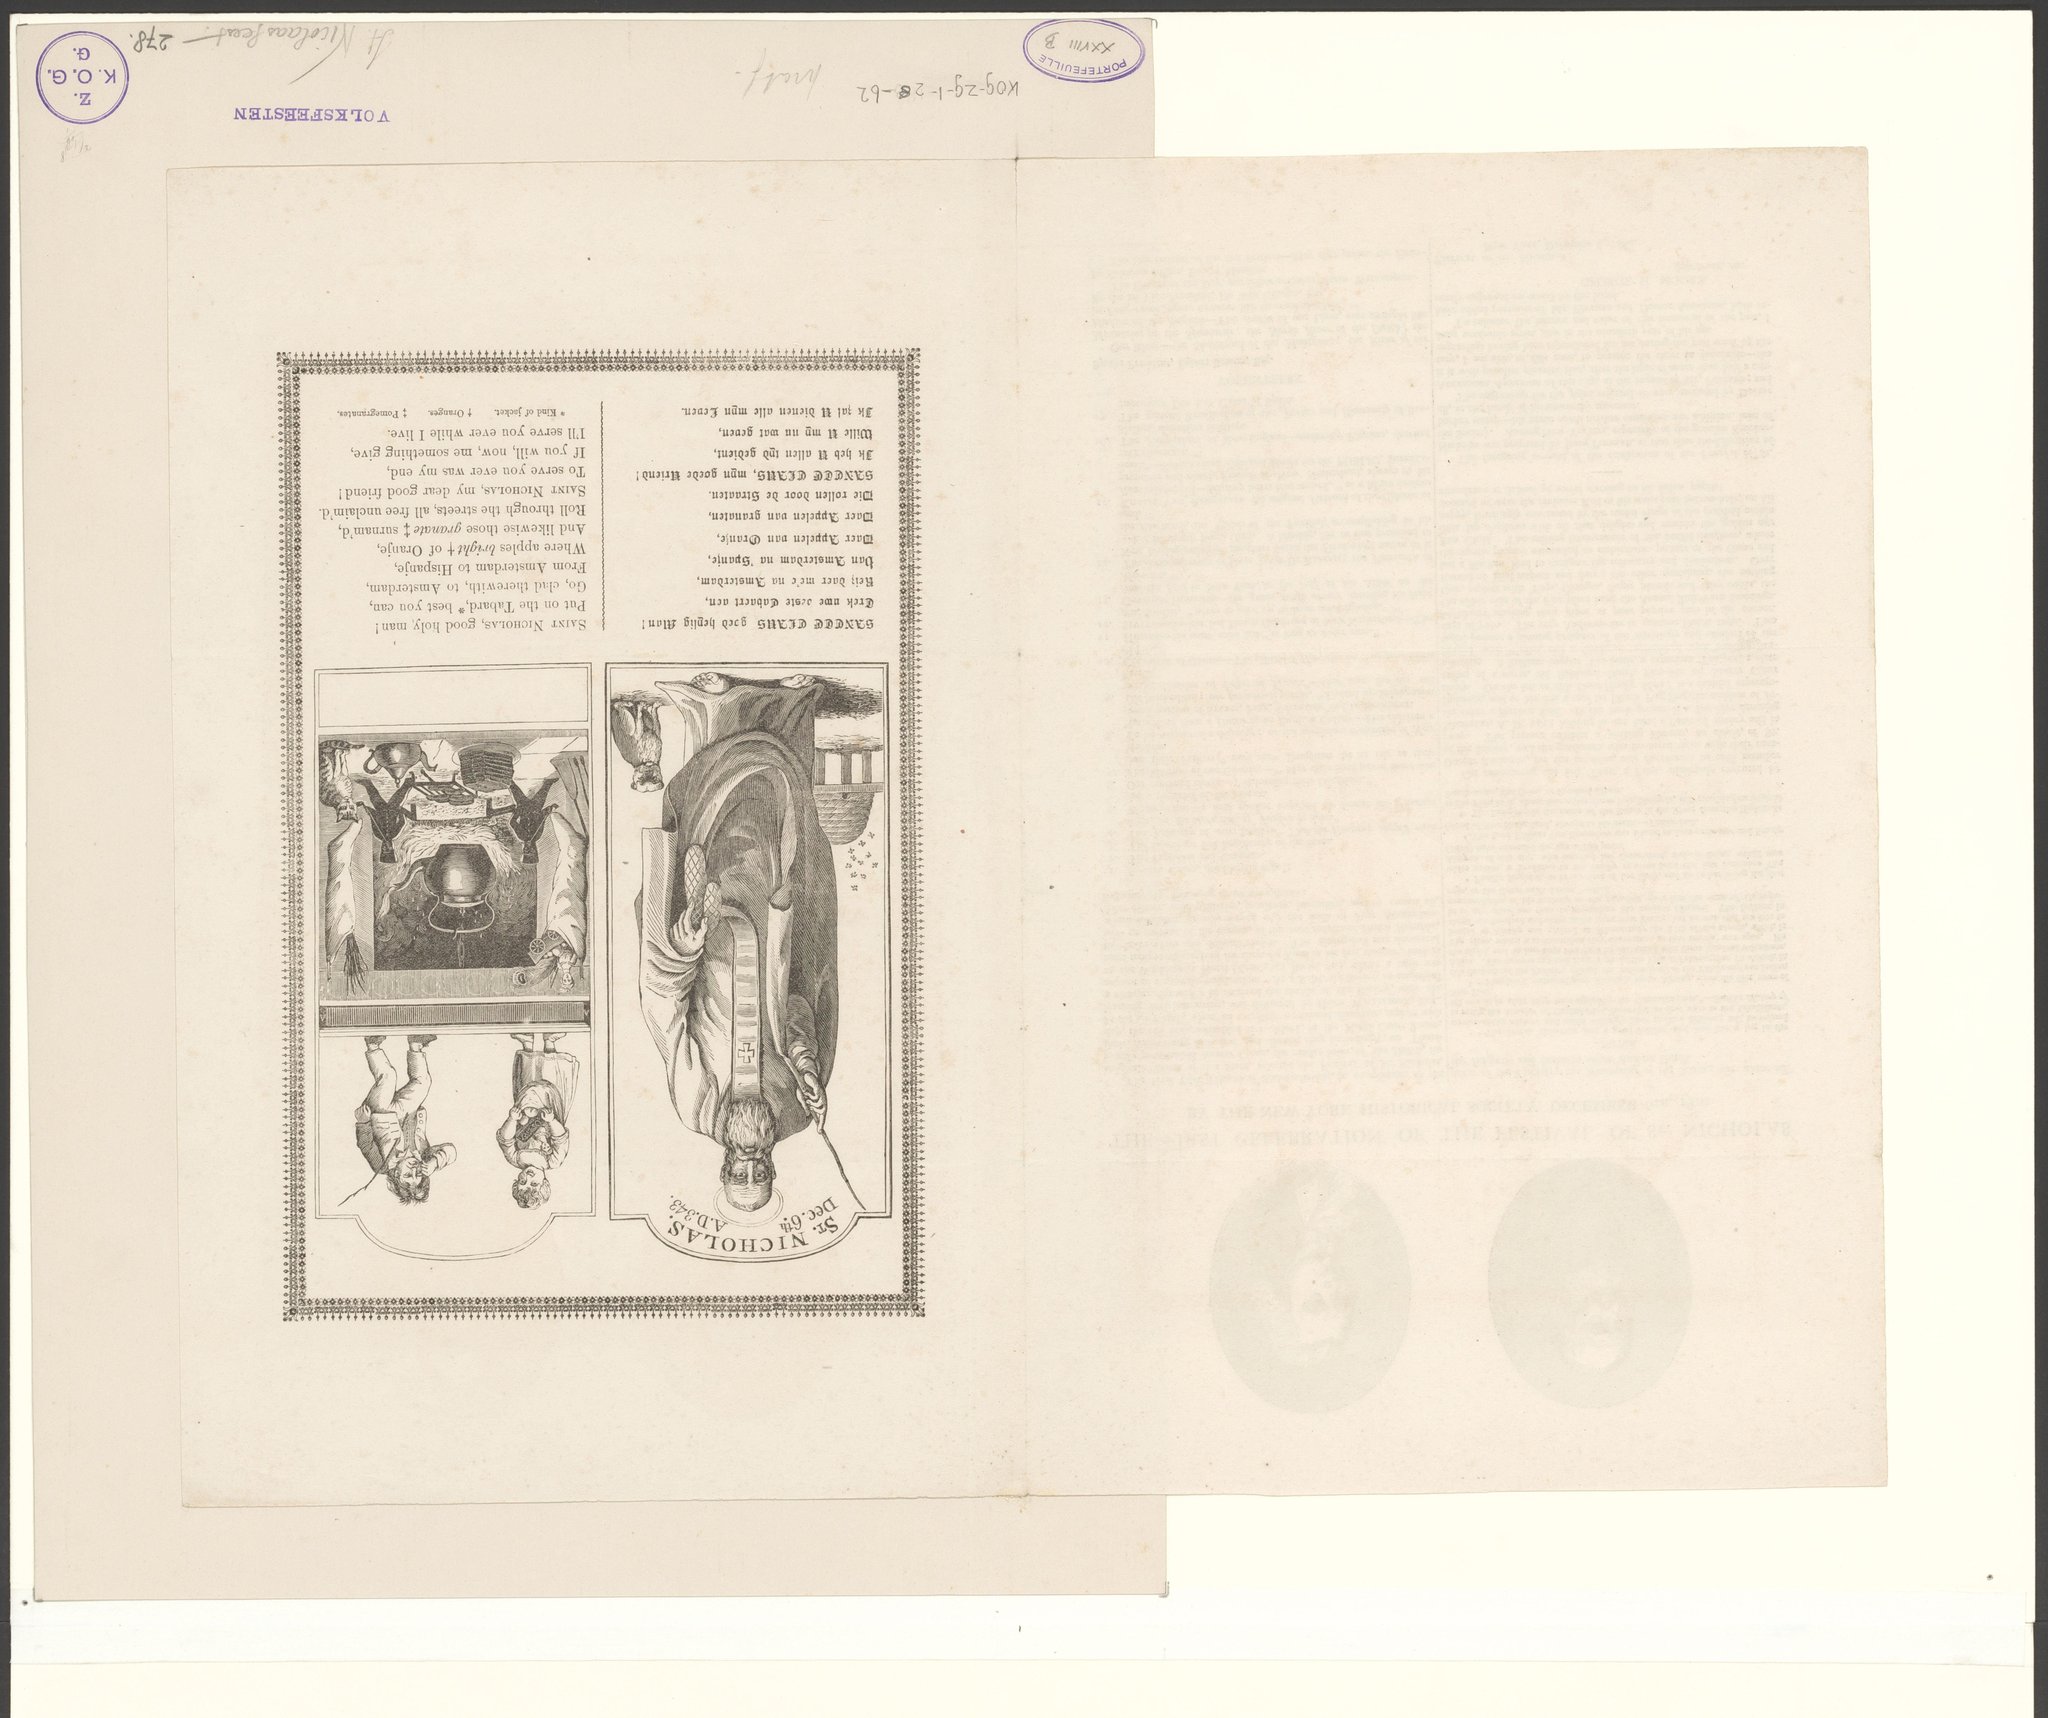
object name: print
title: Sint Nicolaas, een blij kind en een verdrietig kind en een ketel boven het vuur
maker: Anonymous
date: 1864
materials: paper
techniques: letterpress printing, engraving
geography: new york city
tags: the bishop nicholas of myra (or bari); possible attributes: anchor, boat, three golden balls (on a book), three purses, three children in a tub, three maidens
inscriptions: stamp, collector's mark: Lugt 1641, stamp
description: Onderwerpsrubrieken binnen de Atlas Zeden en Gewoonten: Zeden en Gewoonten in Engeren Zin. Volksleven. Volksfeesten. St. Nicolaas.